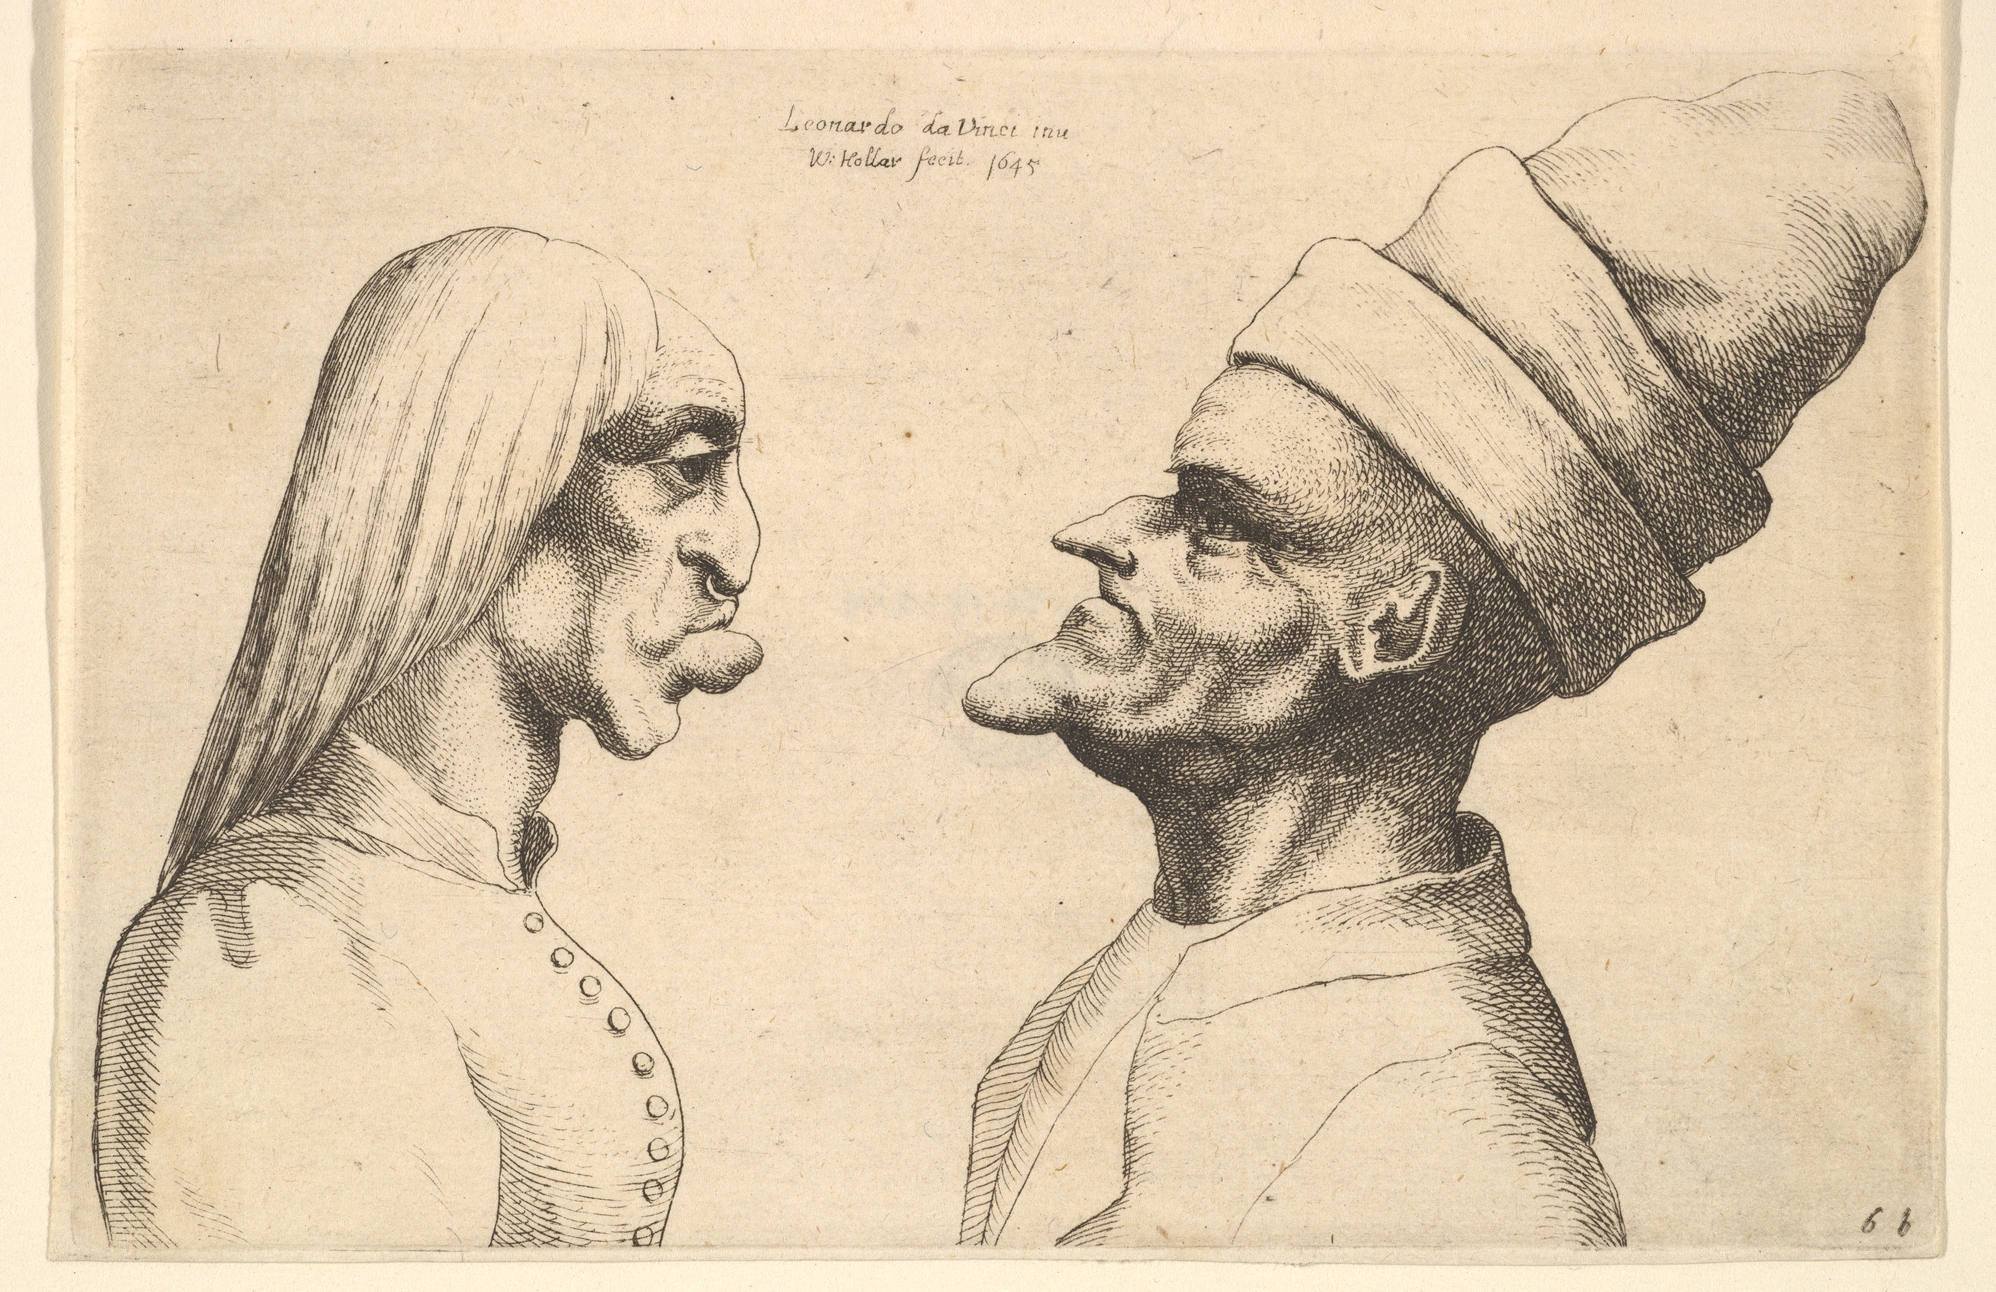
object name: print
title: Two deformed heads facing each other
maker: wenceslaus hollar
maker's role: artist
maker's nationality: bohemian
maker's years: 1607-1677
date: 1645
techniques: etching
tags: couples,men,women